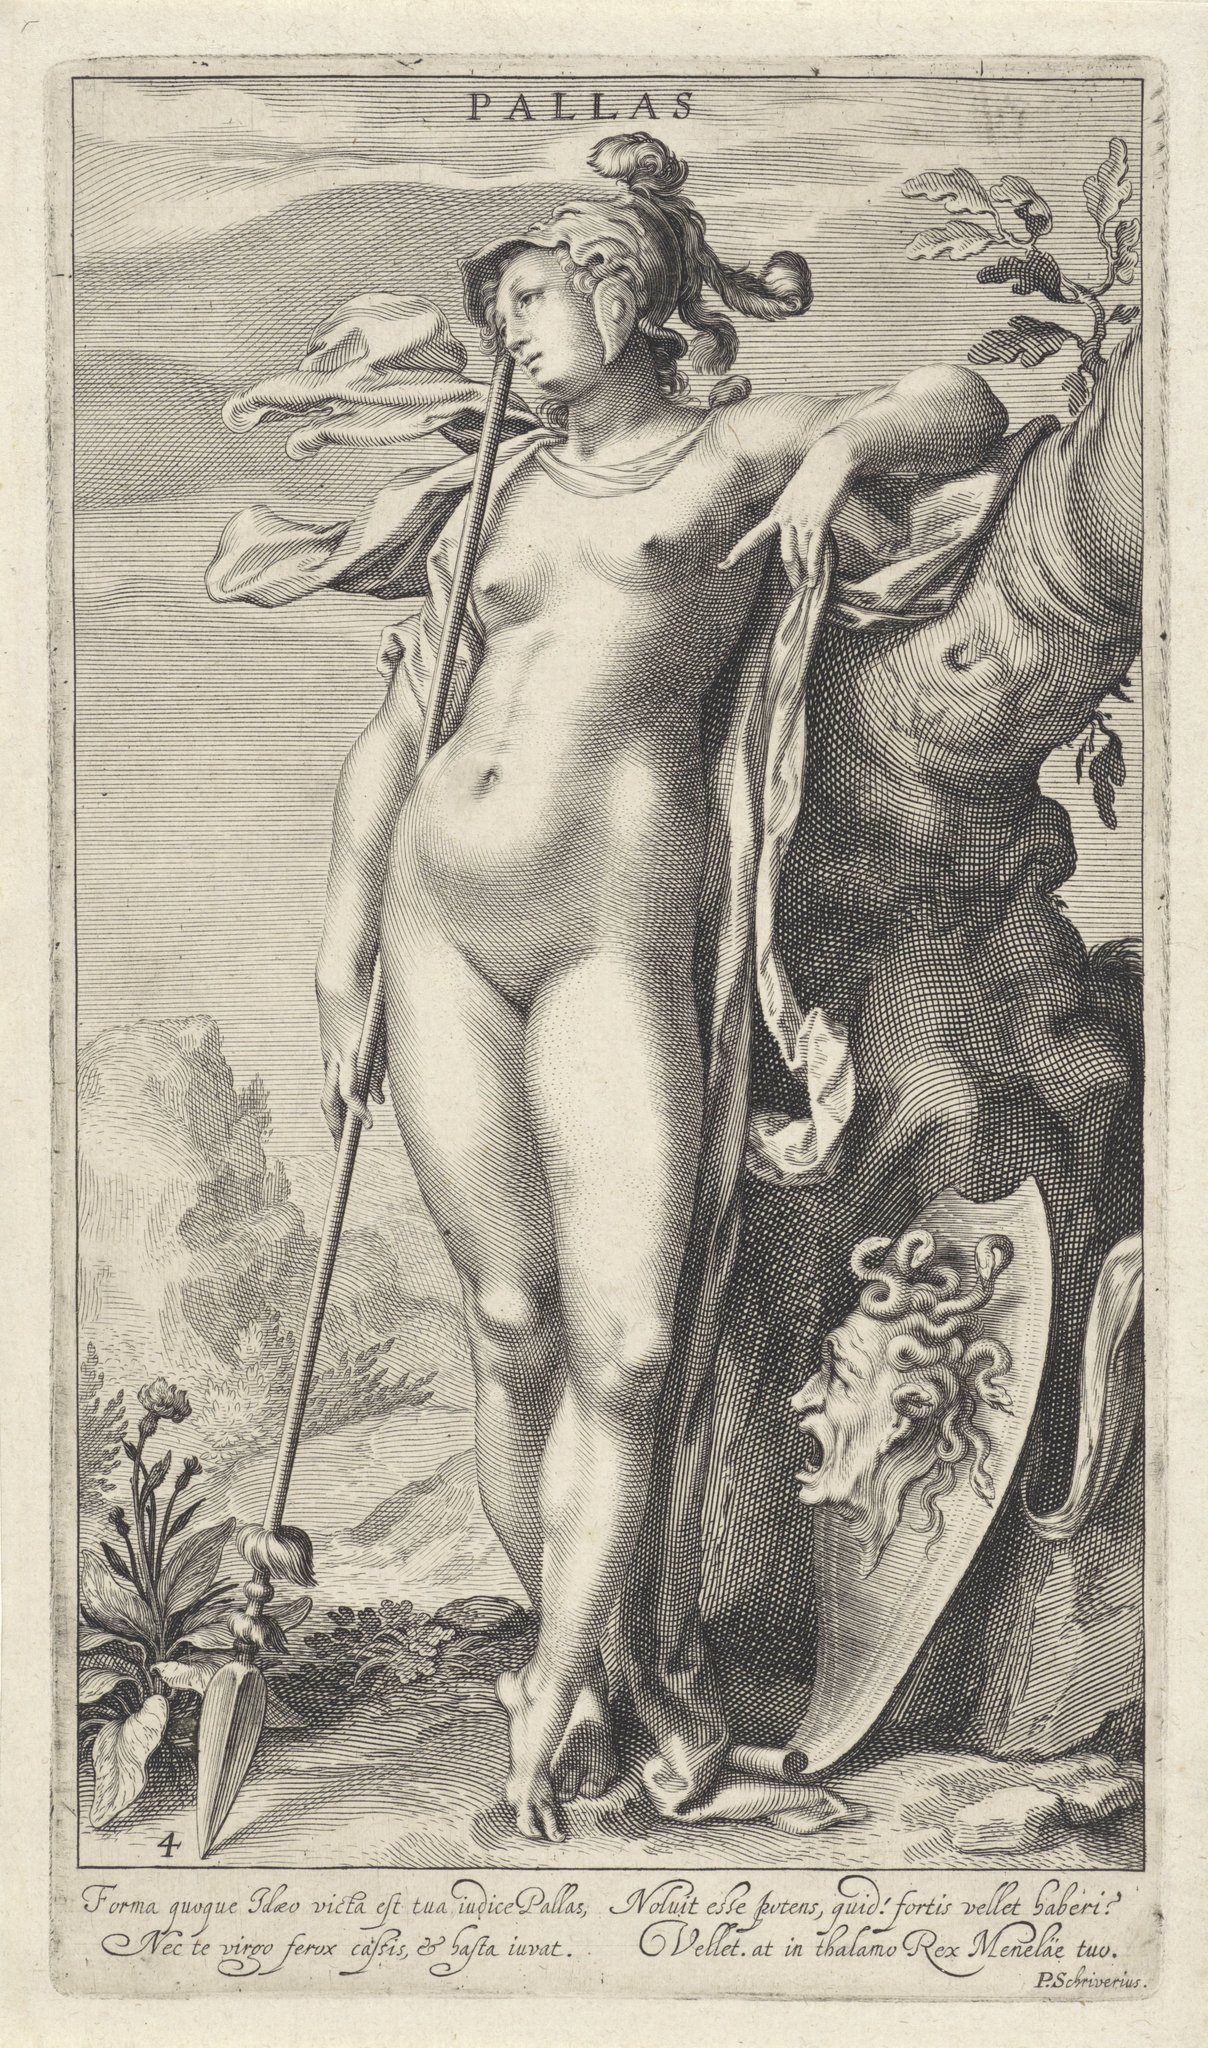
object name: print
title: Pallas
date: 1595-1612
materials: paper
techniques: engraving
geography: delft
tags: helmet, the judgement of paris (mercury present), (story of) minerva (pallas, athena), casting weapons: spear, aegis: shield with gorgon's head (attribute of minerva)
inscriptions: collector's mark: Lugt 240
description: Minerva staat bij een boom. Ze draagt een helm en houdt een speer vast. Tegen de boom staat het schild met het hoofd van Medusa. Onder de voorstelling bevindt zich een vierregelige, Latijnse tekst met een beschrijving van Minerva's belofte aan Paris.